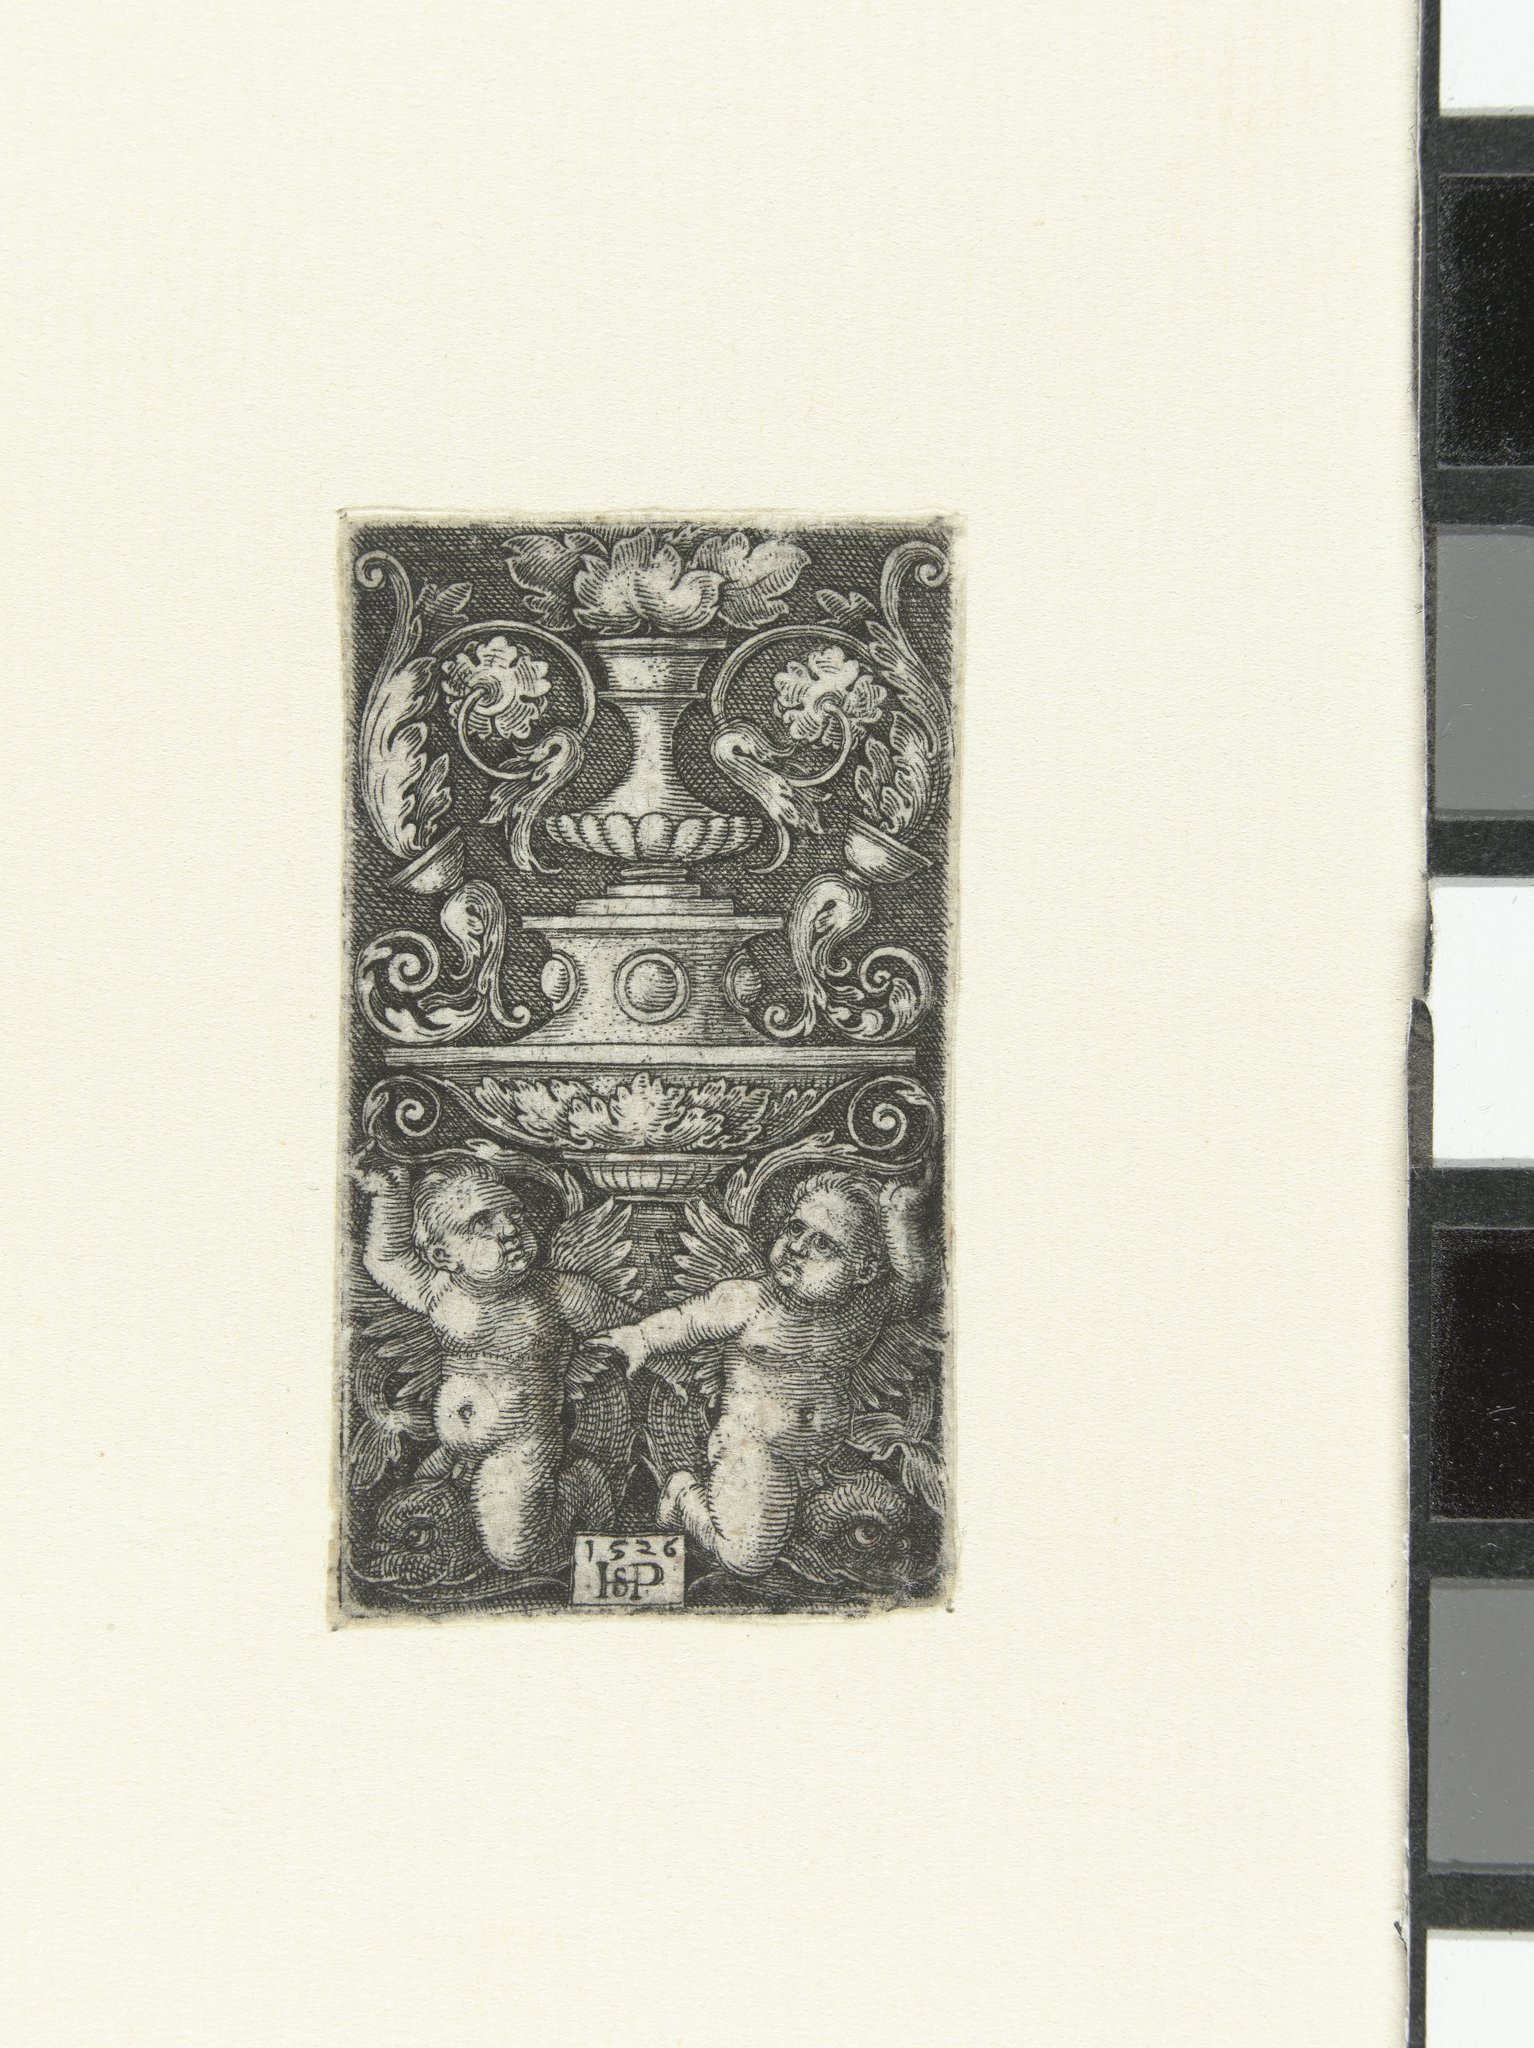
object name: print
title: Vlakdecoratie met twee putti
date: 1510-1526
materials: paper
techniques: engraving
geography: germany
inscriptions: collector's mark: Lugt 240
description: Twee putti, die elk op een dolfijn zitten, houden een vaas omhoog die gedecoreerd is met bladranken. Gearceerde achtergrond.